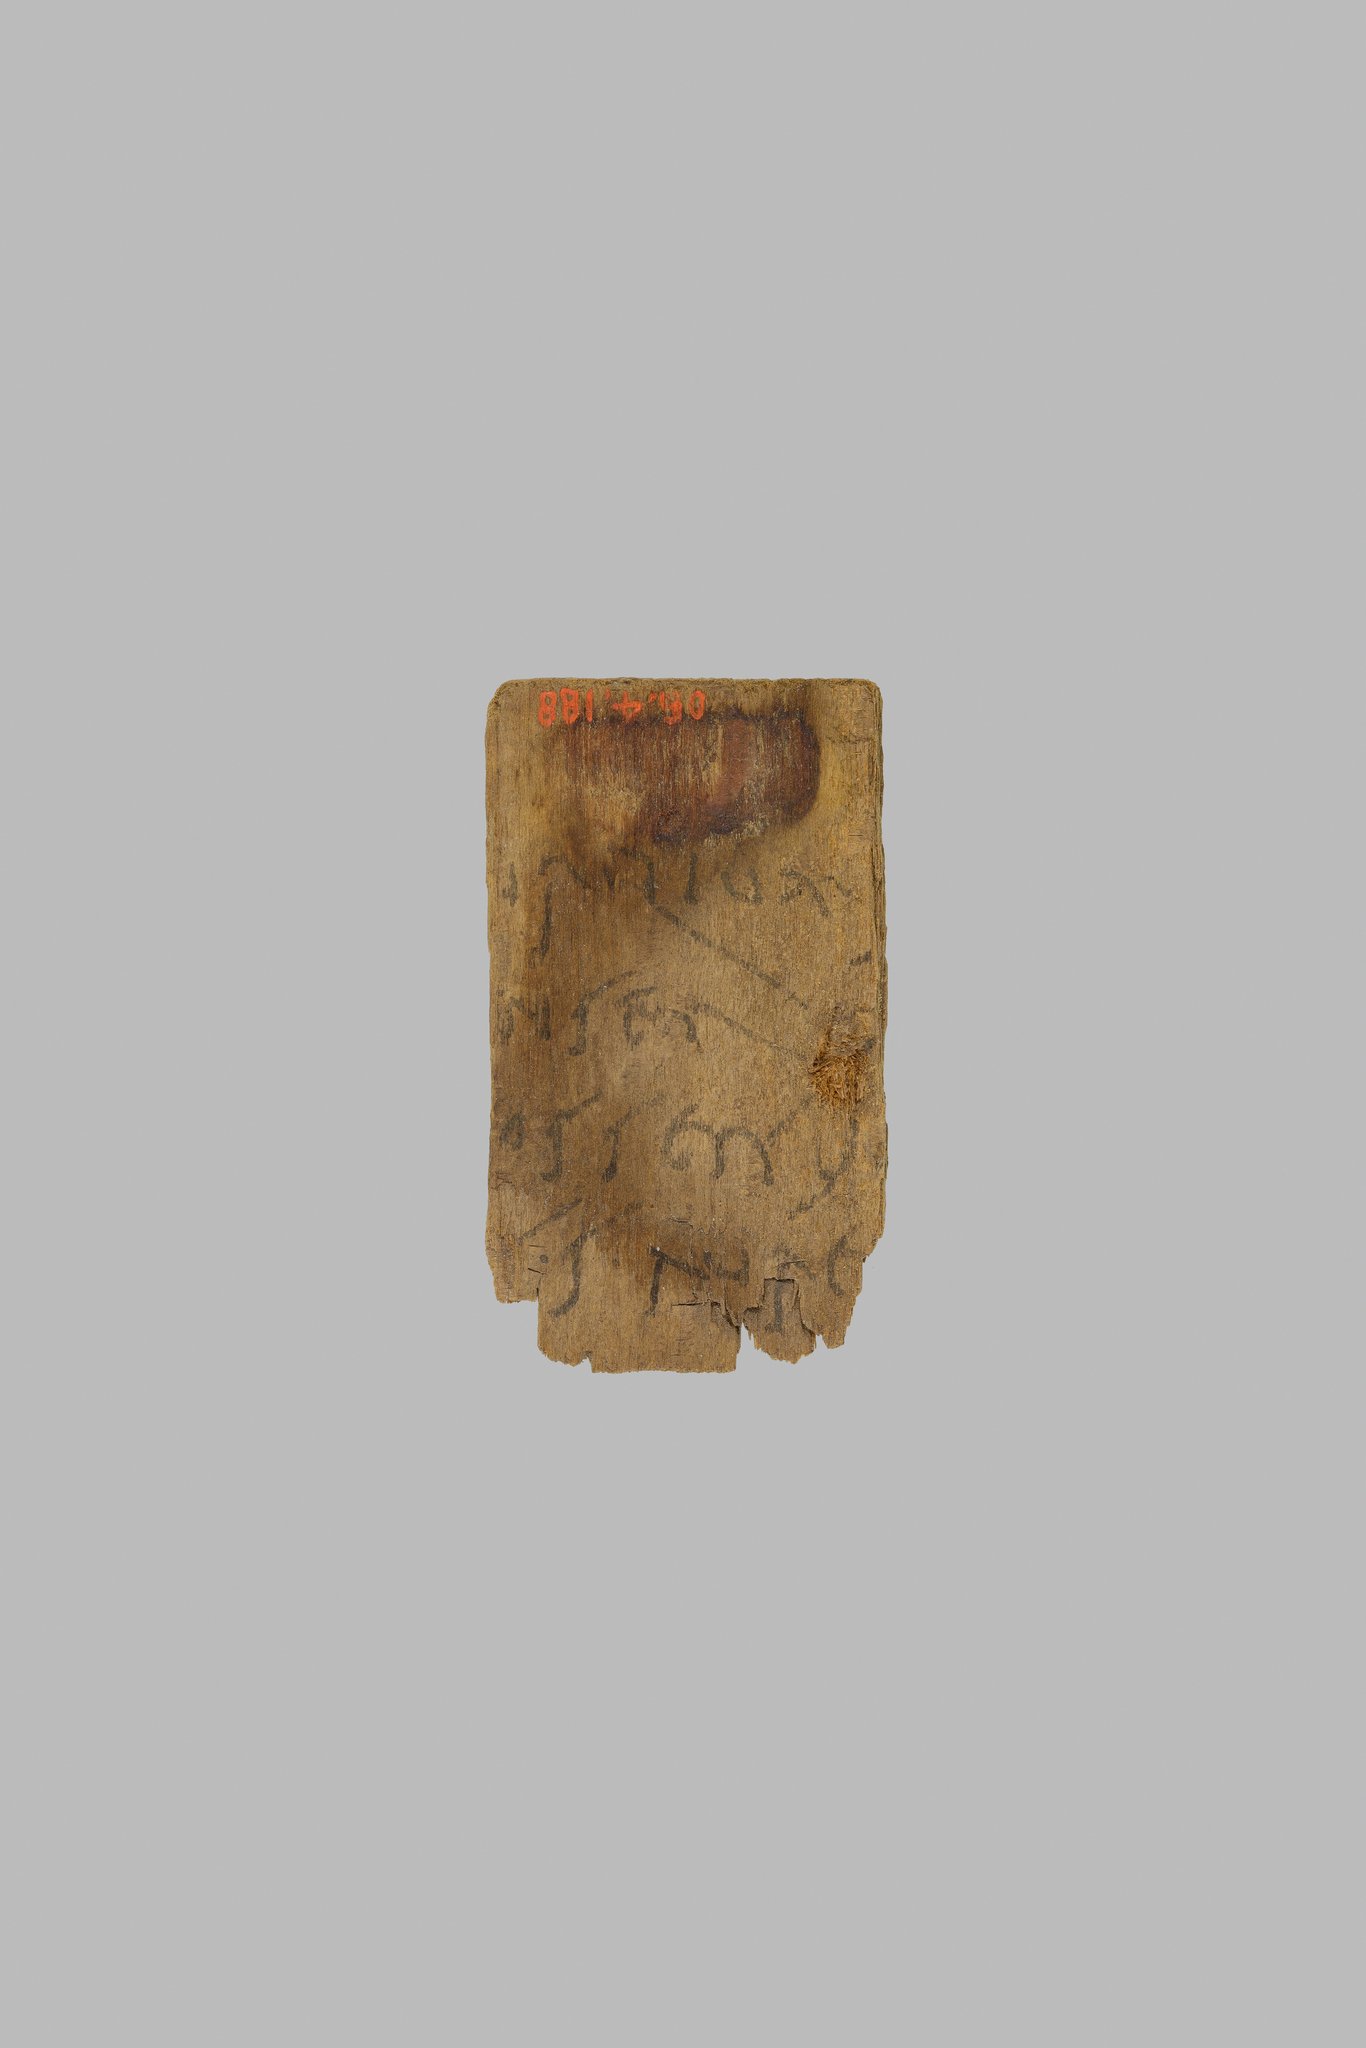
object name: mummy label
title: Fragment of a mummy label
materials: ink, wood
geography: egypt